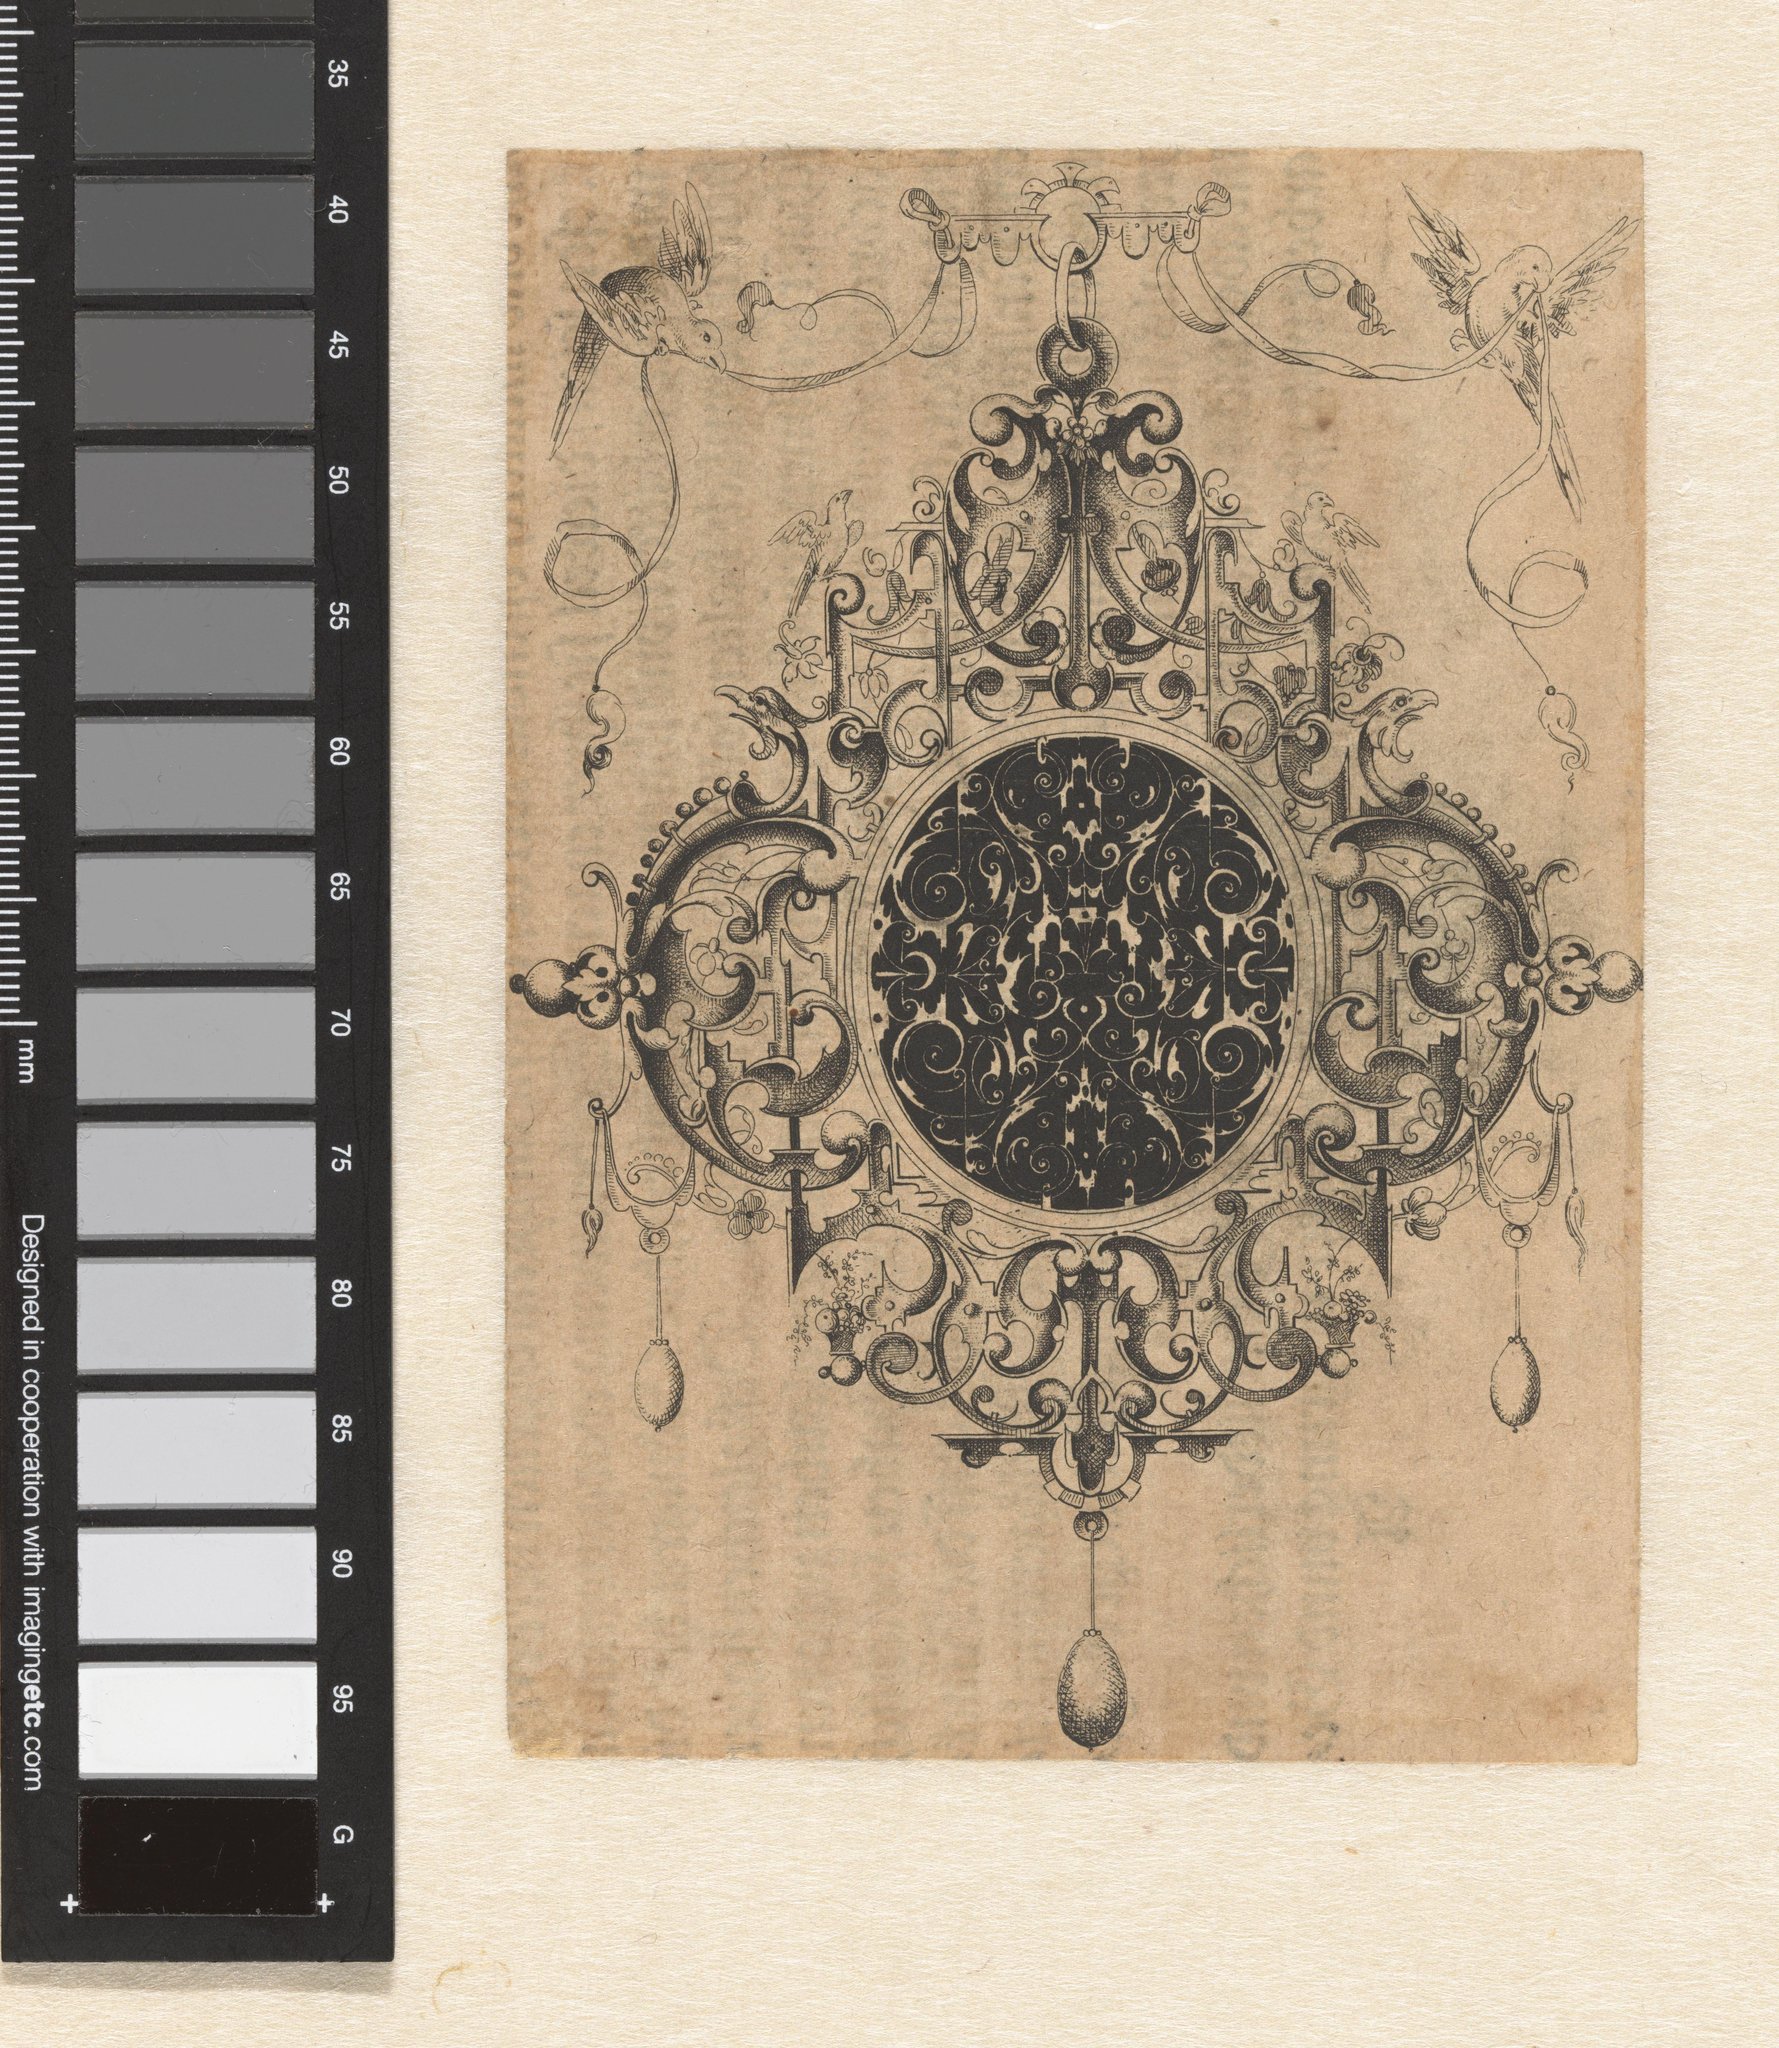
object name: ornament print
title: Ornamentele hanger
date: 1609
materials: paper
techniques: engraving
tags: ornaments ~ art, pendant, trinket, 'breloque'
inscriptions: collector's mark: Lugt 2760, collector's mark: Lugt 2228, :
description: Mogelijke kopie, want verschilt met exemplaar in British Museum (2AA+,a.29.4).